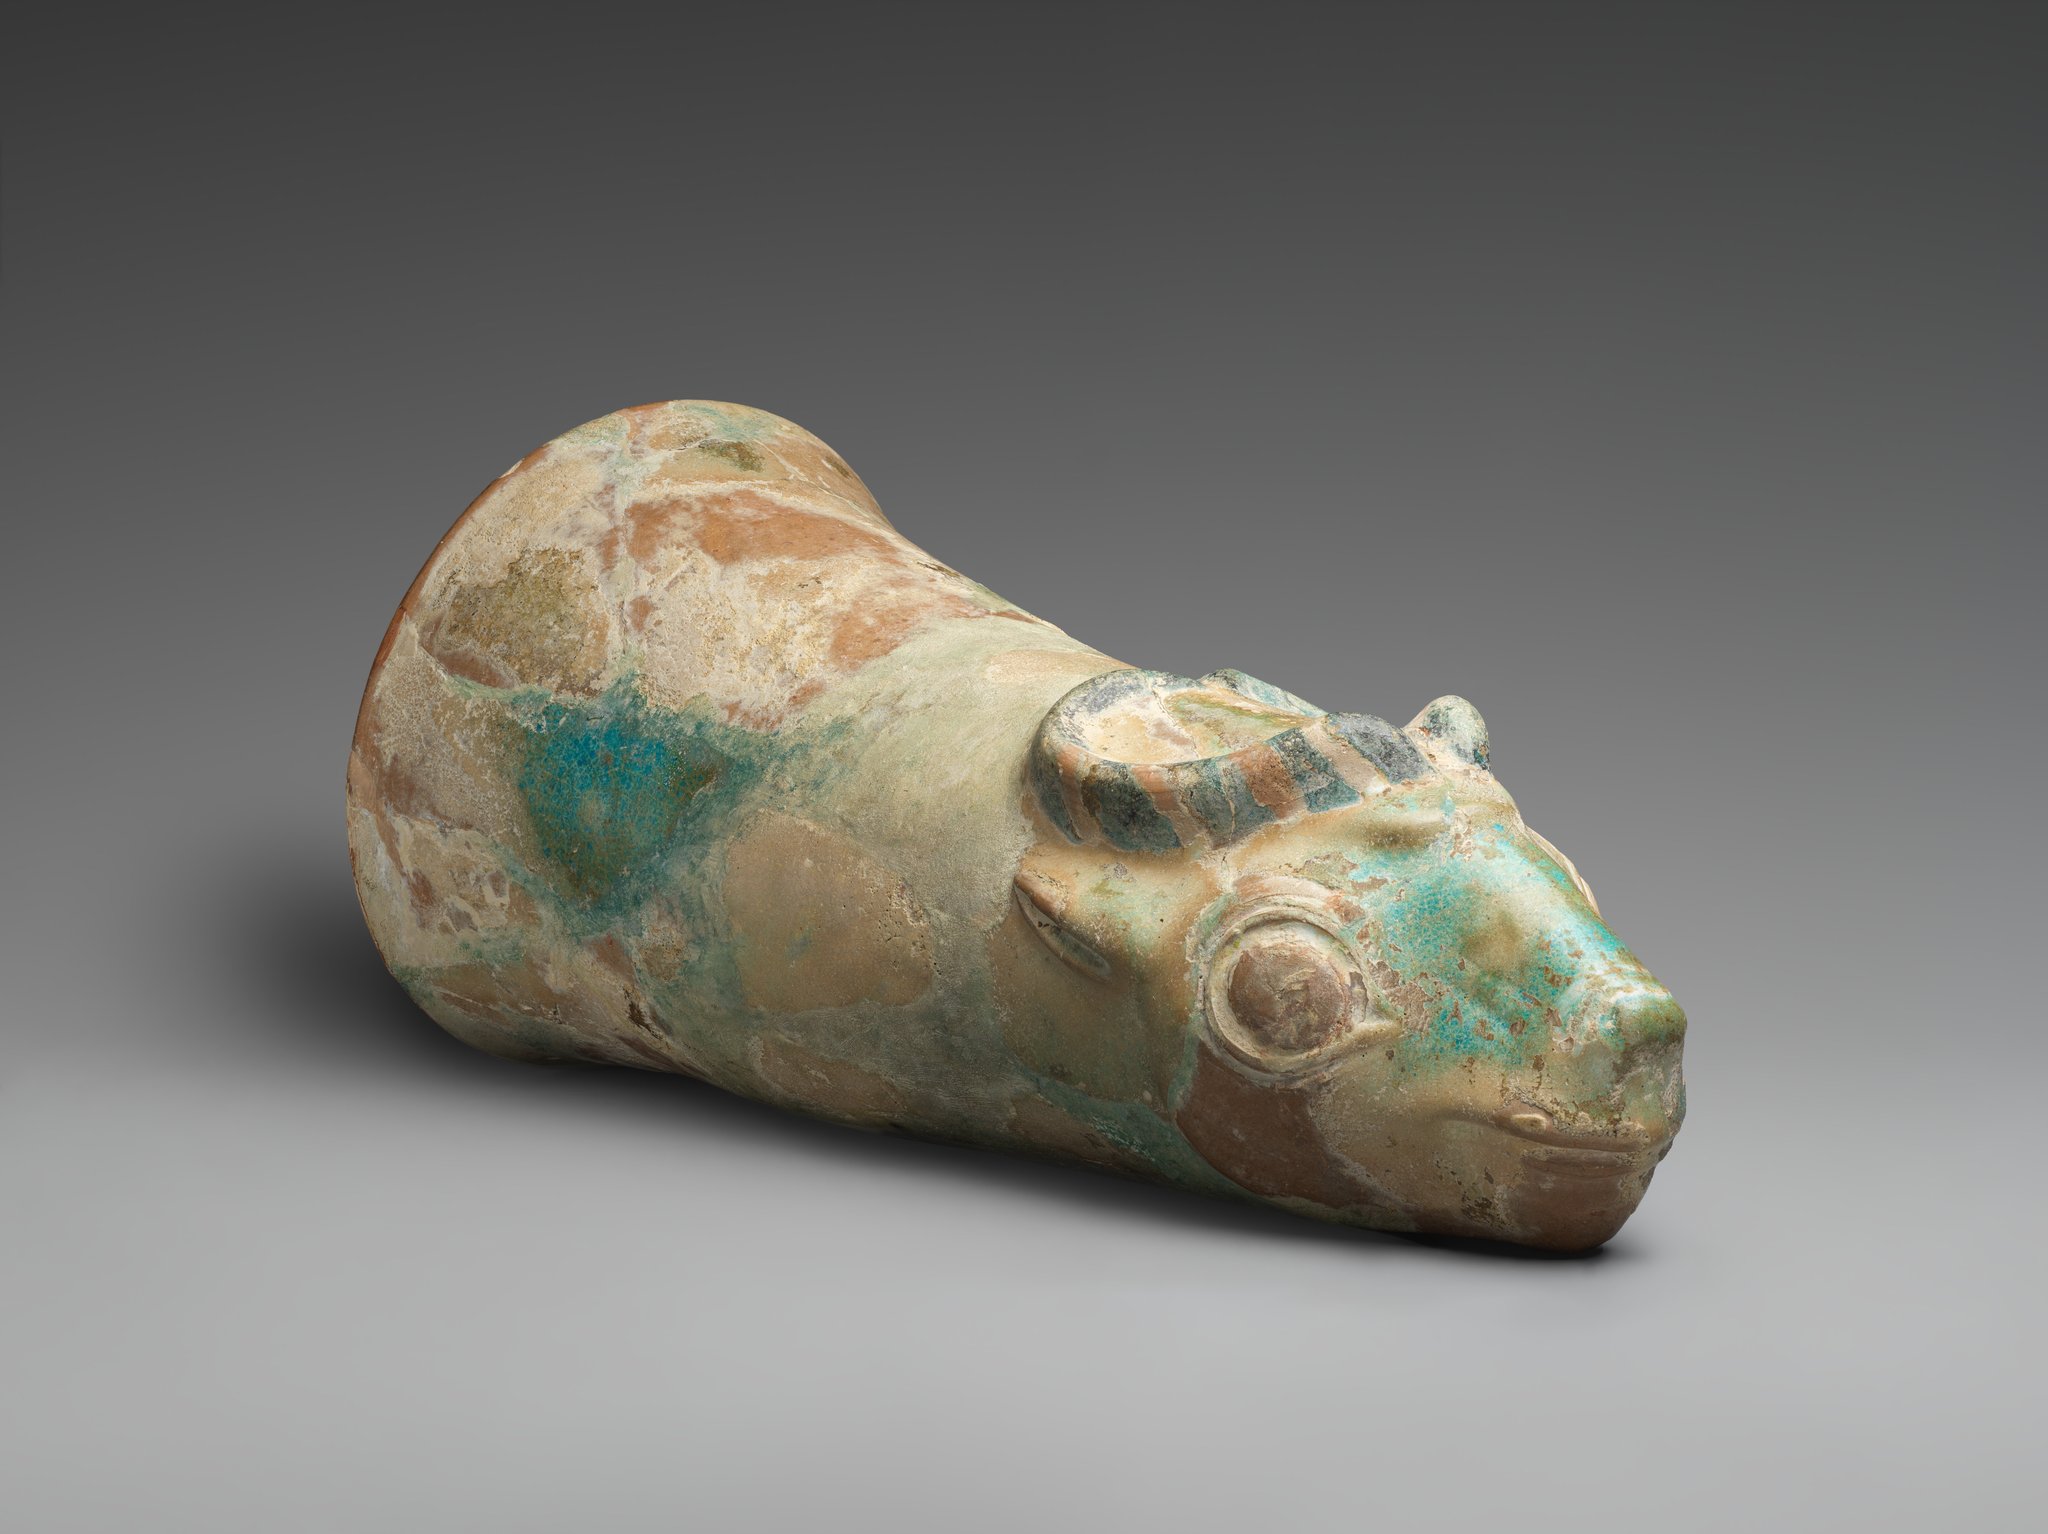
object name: vessel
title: Vessel terminating in the head of an antelope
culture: iranian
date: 800-601 BCE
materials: ceramic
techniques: glazing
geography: iran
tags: animals